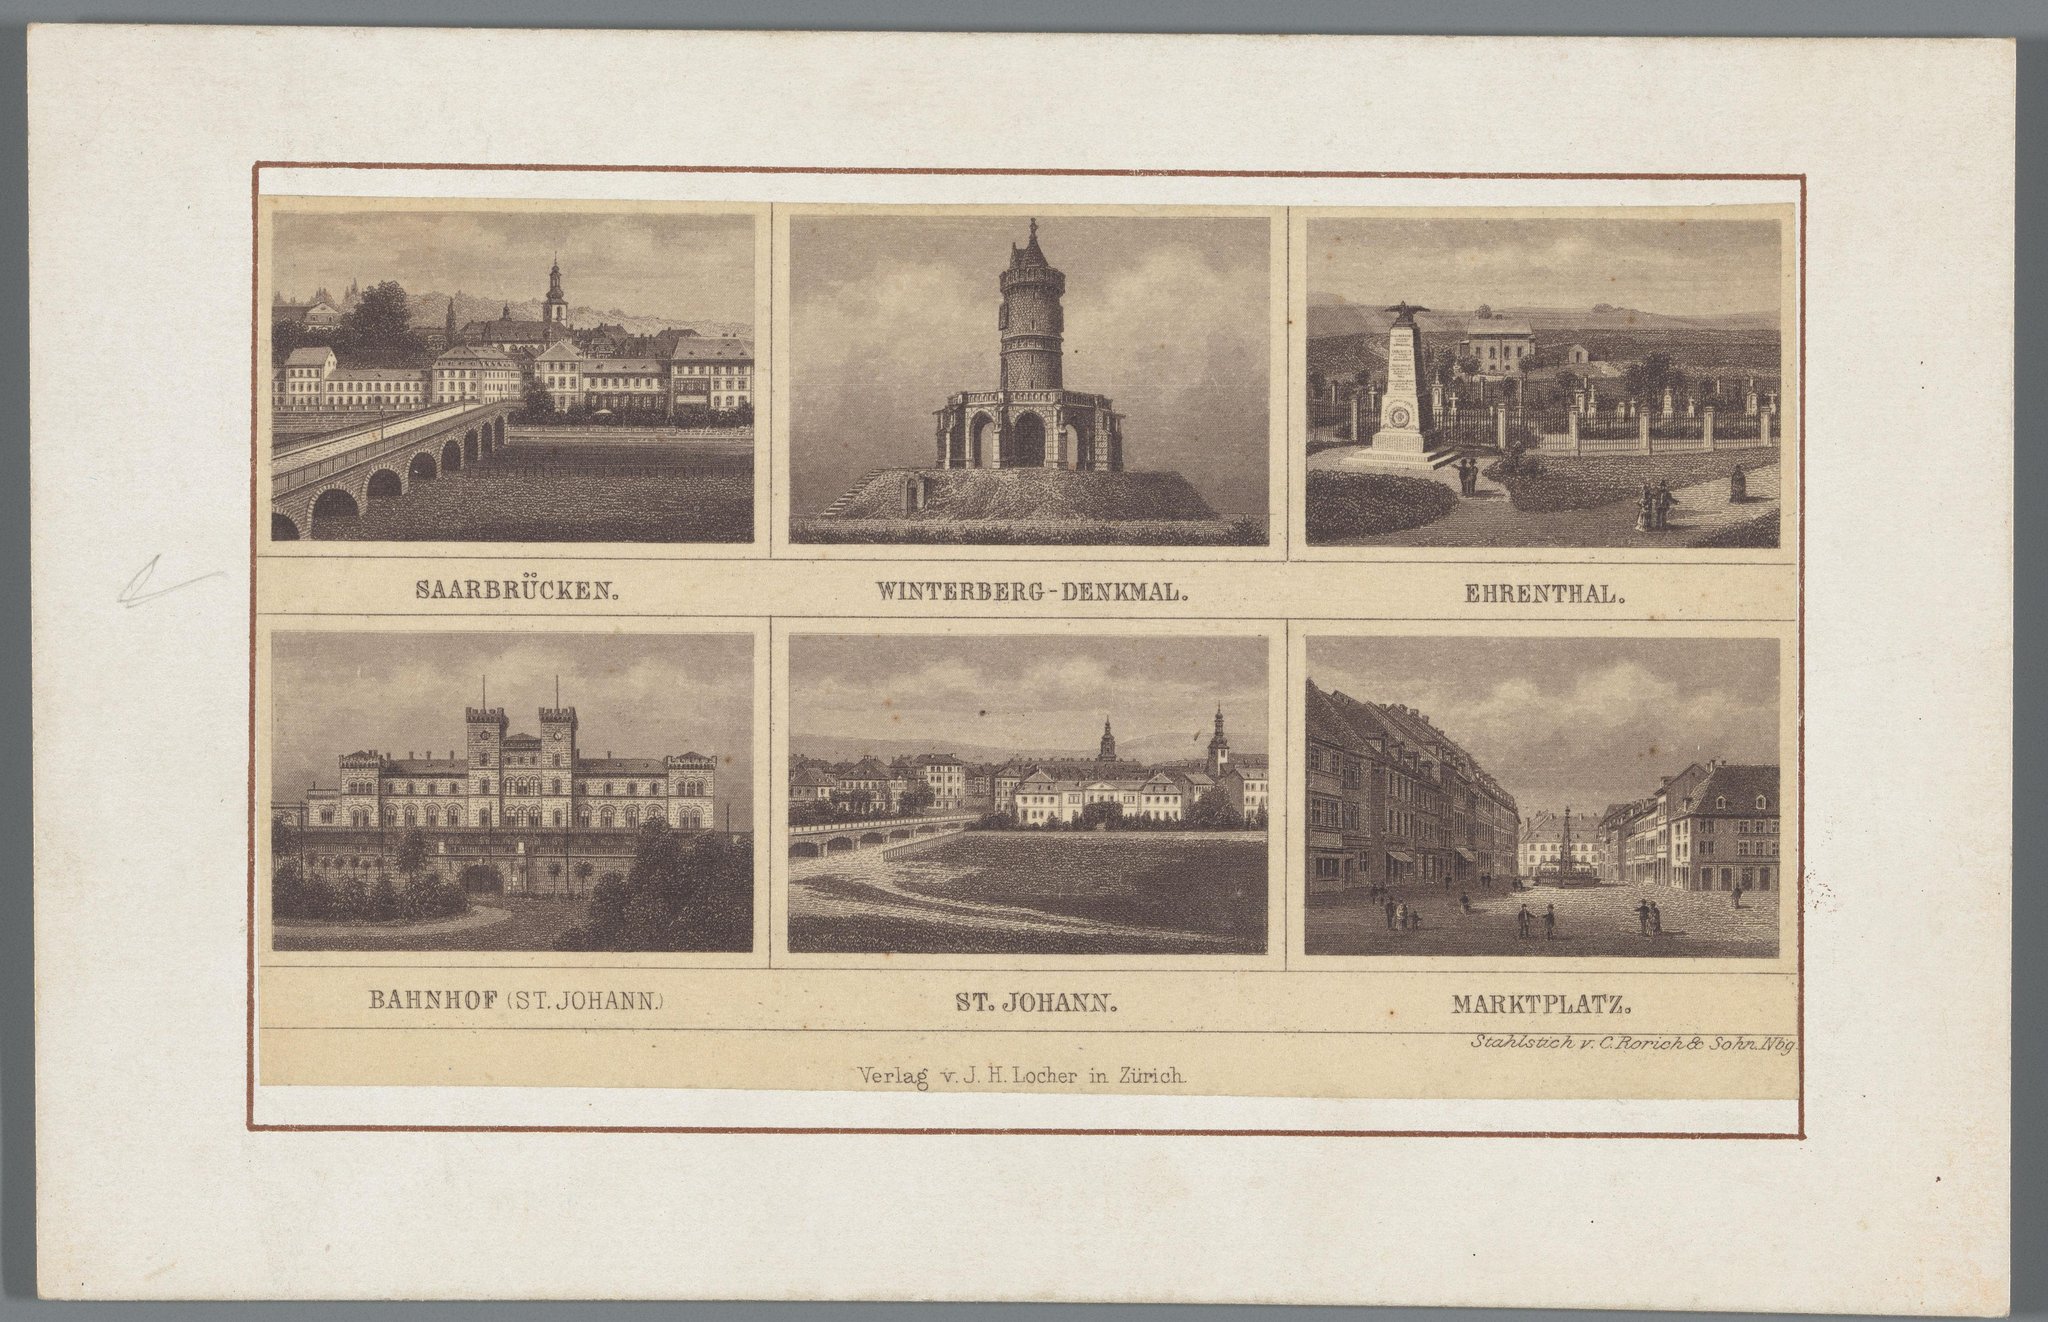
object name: reproduction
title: Reproductie van zes gezichten in Saarbrücken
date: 1855-1892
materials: cardboard, paper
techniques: photolithography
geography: saarbrücken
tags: city-view in general; 'veduta'